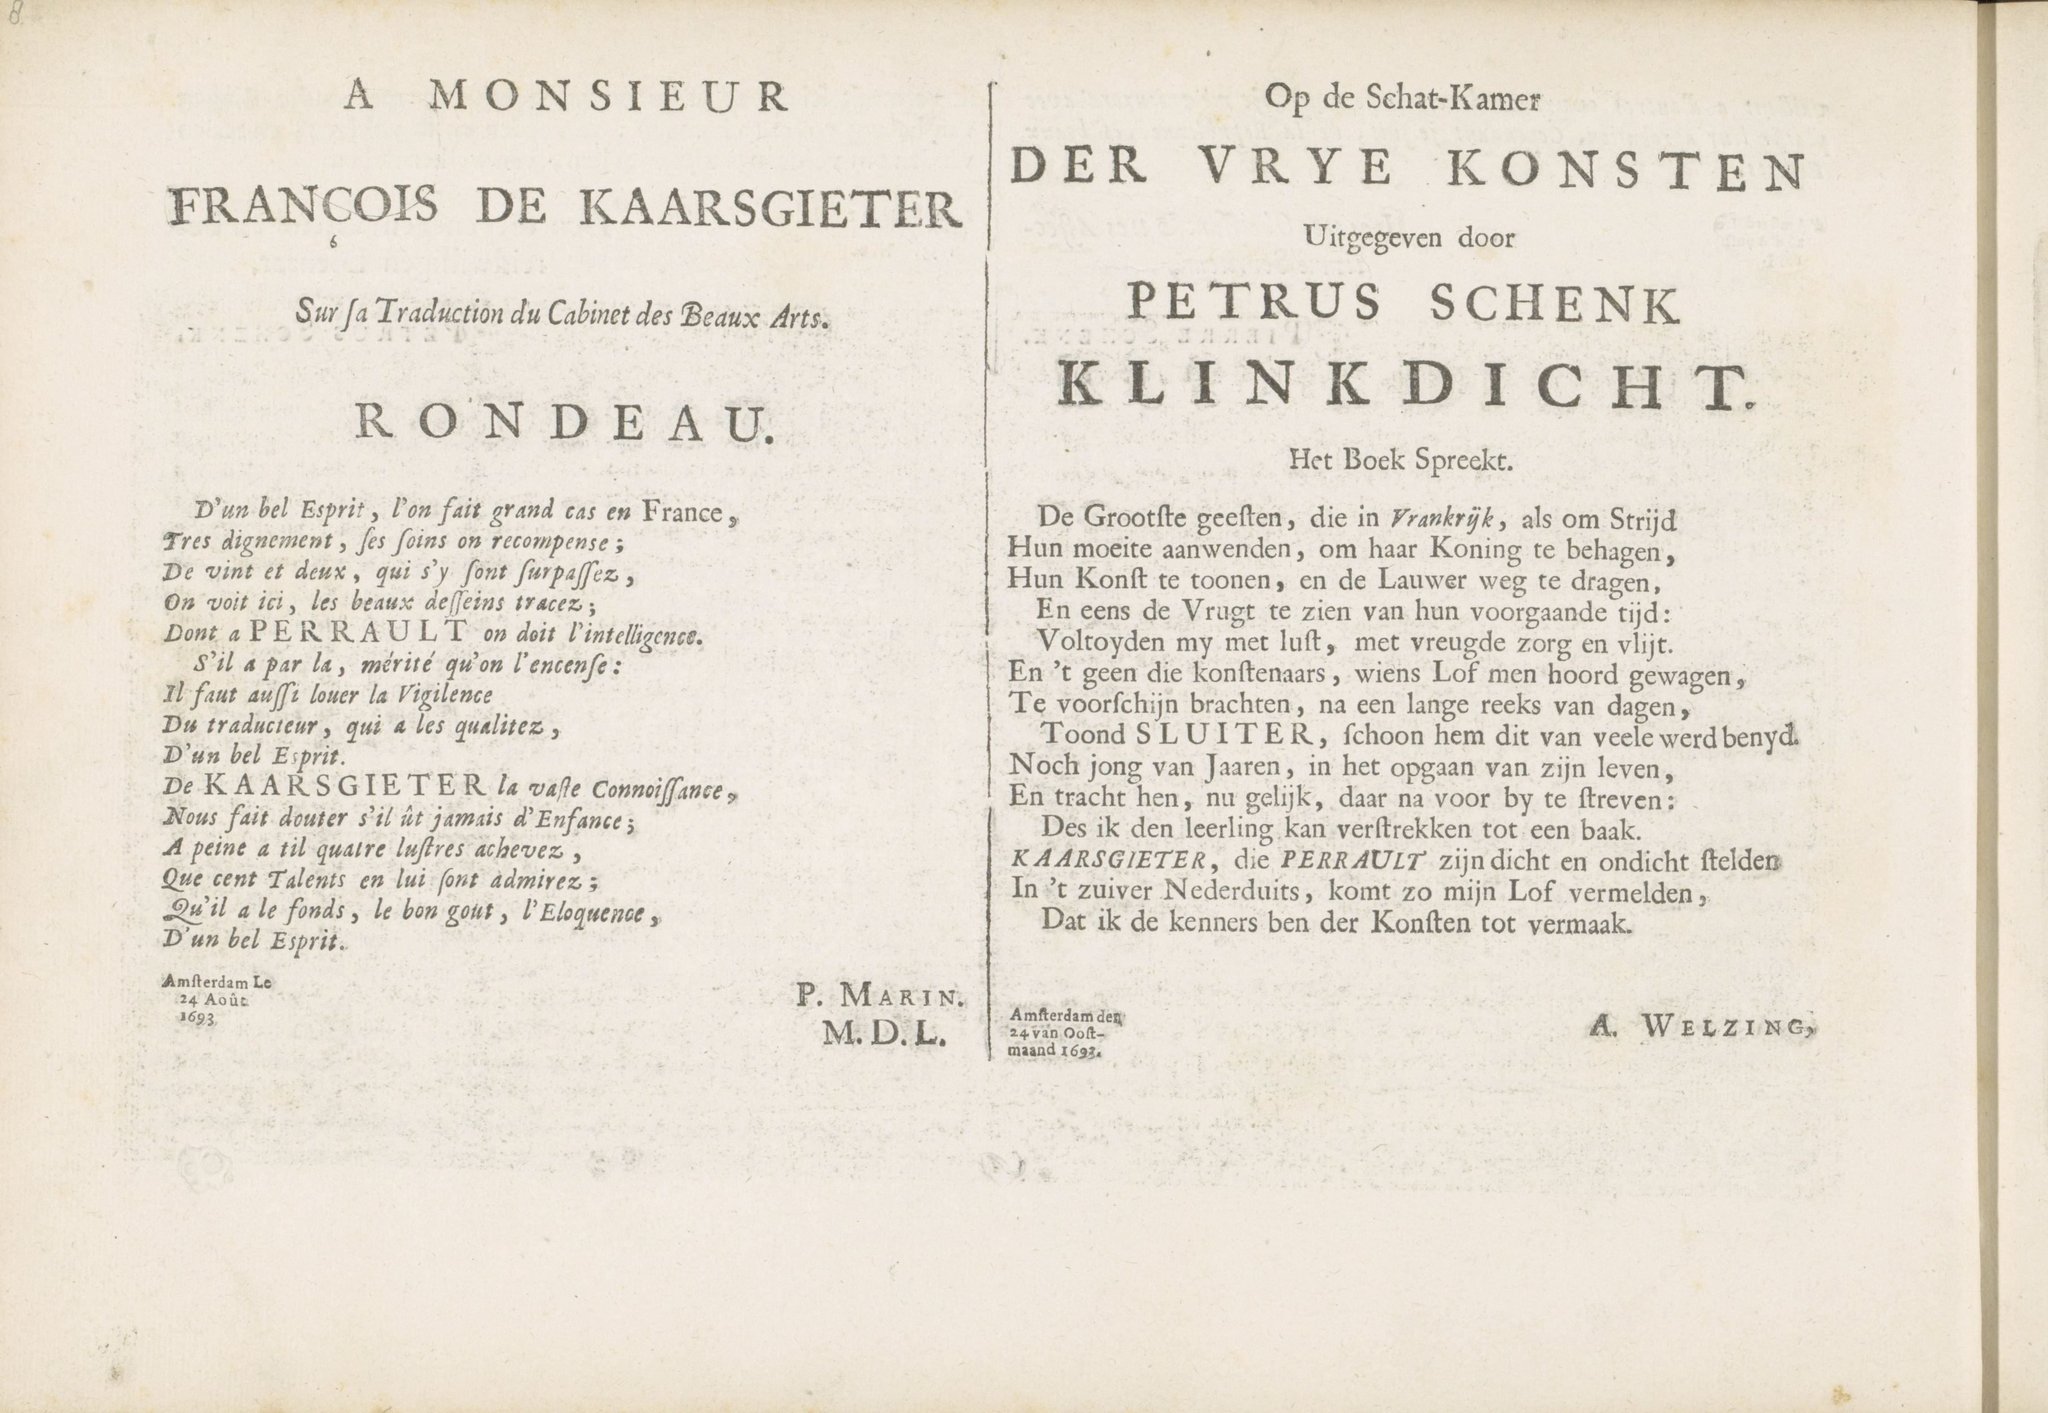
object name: text sheet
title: A Monsieur François de Kaarsgieter (...) / Op de Schat-Kamer der Vrye Konsten (...)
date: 1693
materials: paper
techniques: letterpress printing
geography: amsterdam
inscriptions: date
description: Opdracht aan vertaler François de Kaarsgieter en gedichten in het Frans en het Nederlands. Tekstblad maakt deel uit van een album.